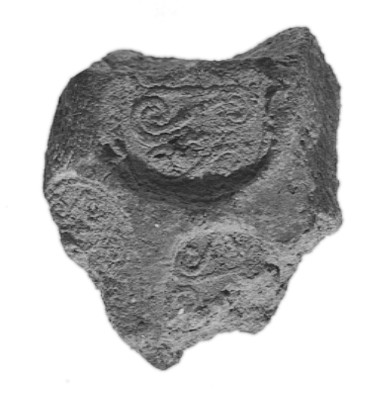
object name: sealing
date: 2030-1640 BCE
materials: clay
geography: egypt